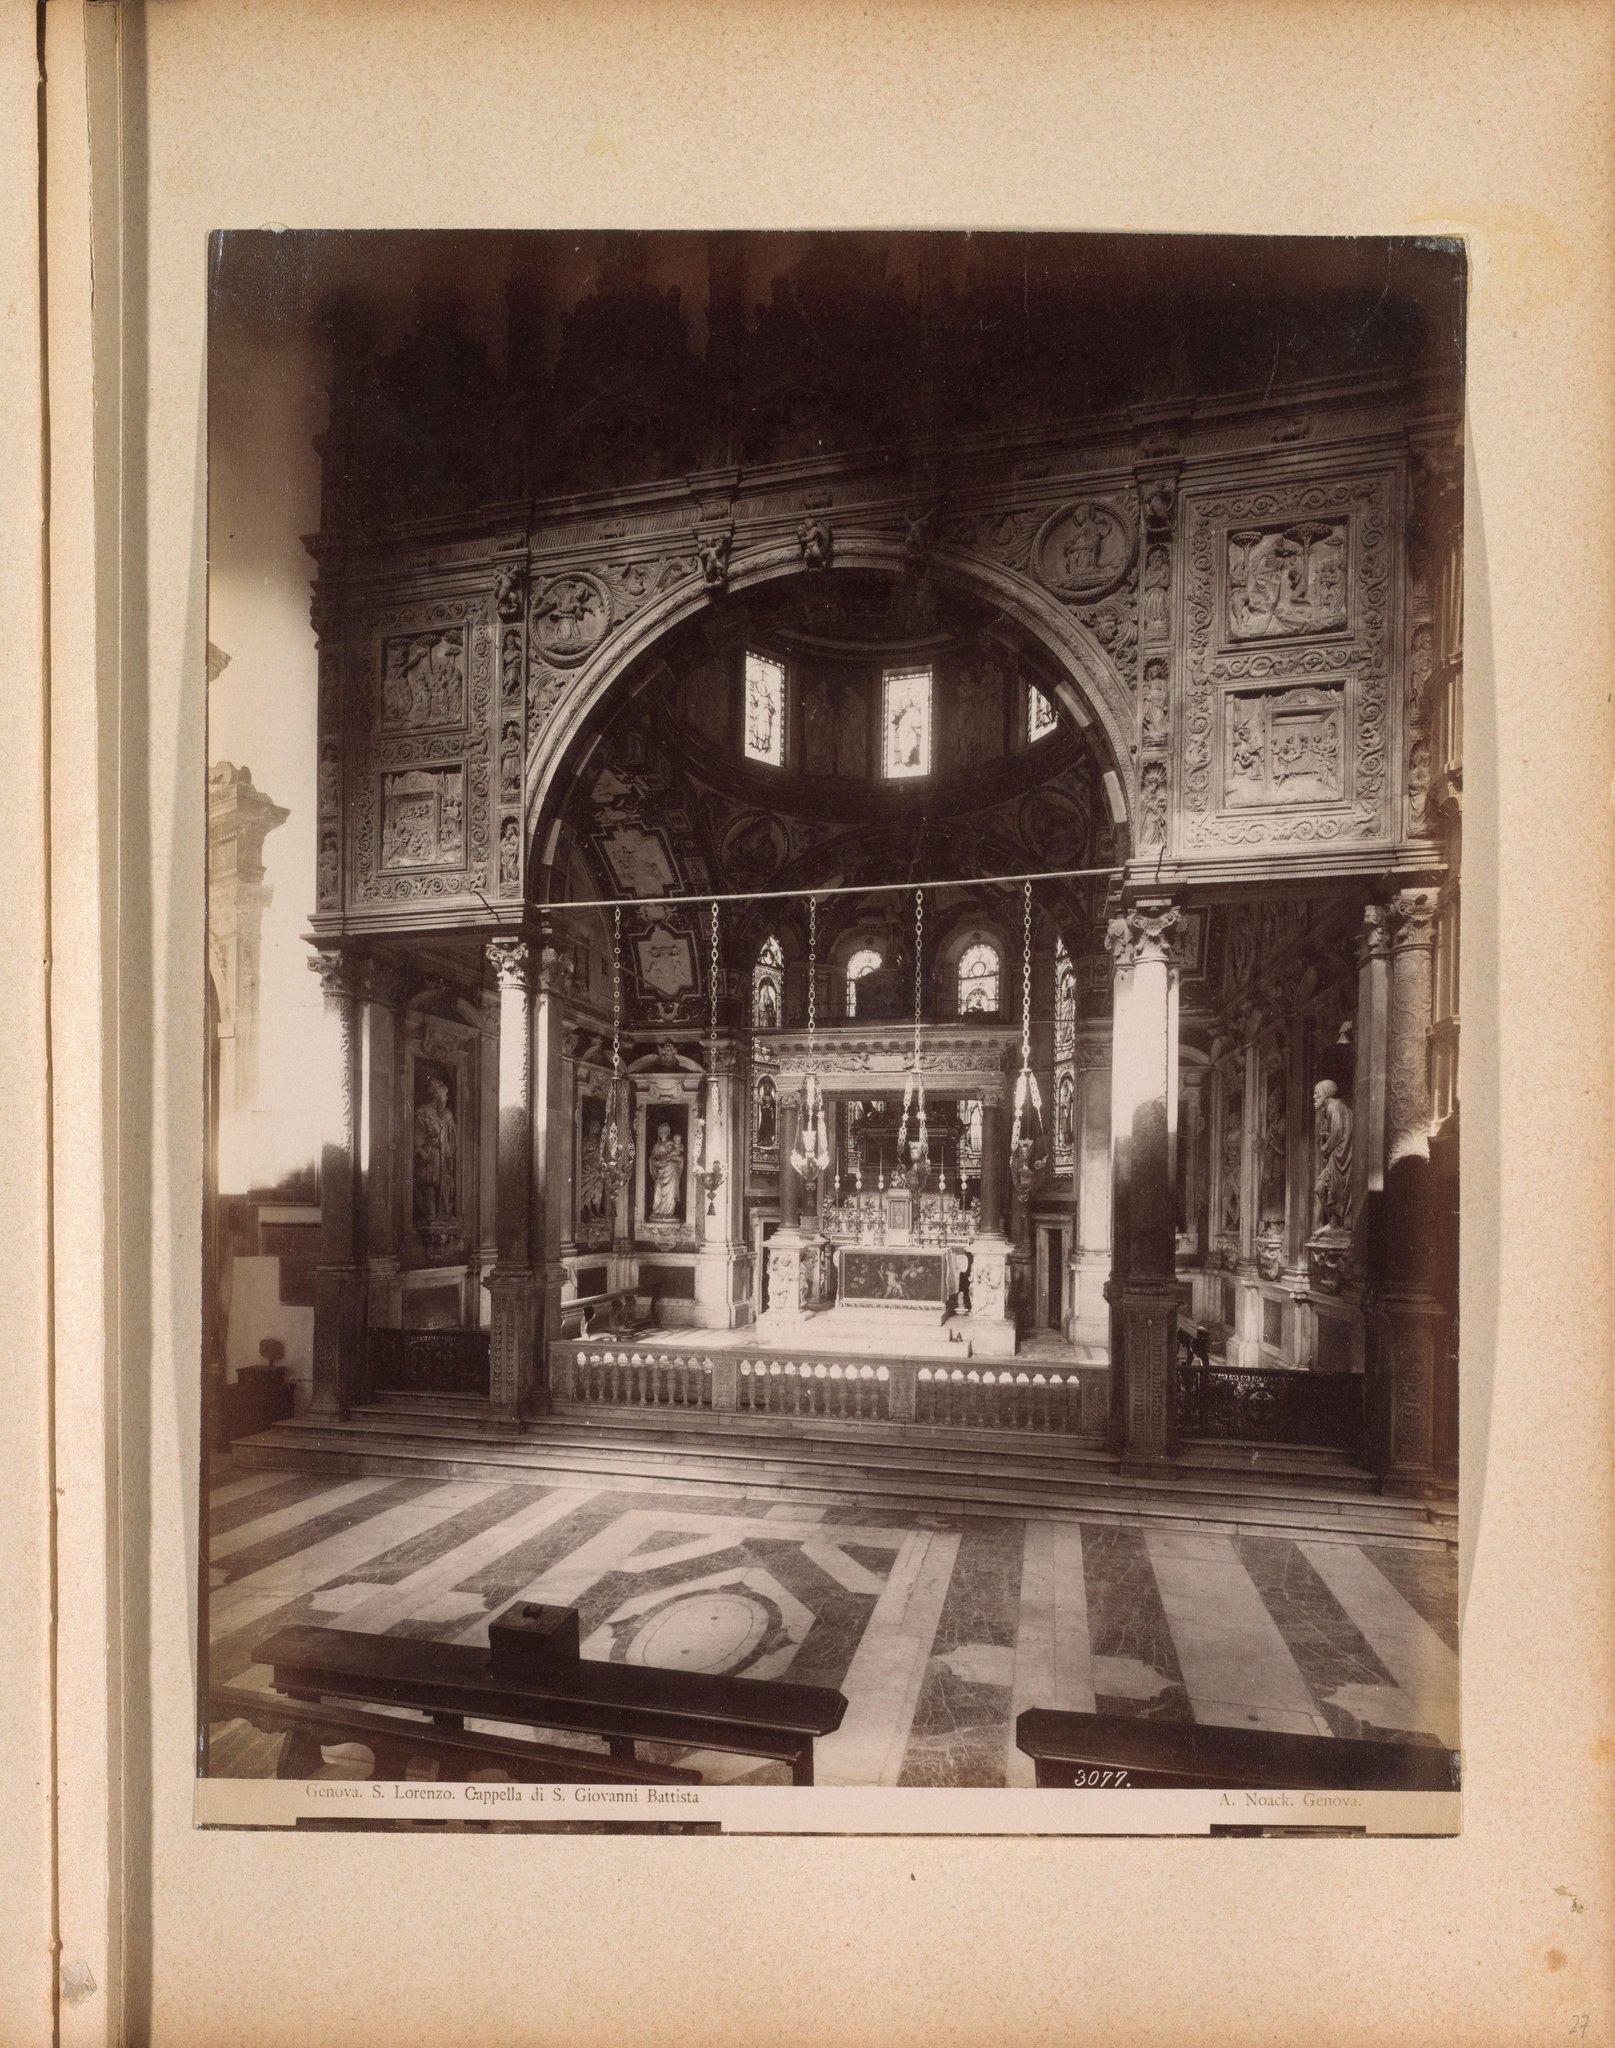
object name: photograph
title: Genova. S. Lorenzo. Capella di S. Giovanni Battista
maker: alfredo noack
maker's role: fotograaf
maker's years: 1833-1895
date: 1870-1900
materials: paper, photographic support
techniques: albumen print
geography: genoa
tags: parts of church interior: chapel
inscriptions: negative number: ‘3077’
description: Onderdeel van Reisalbum met foto's van bezienswaardigheden in Italië en Zuid-Frankrijk.